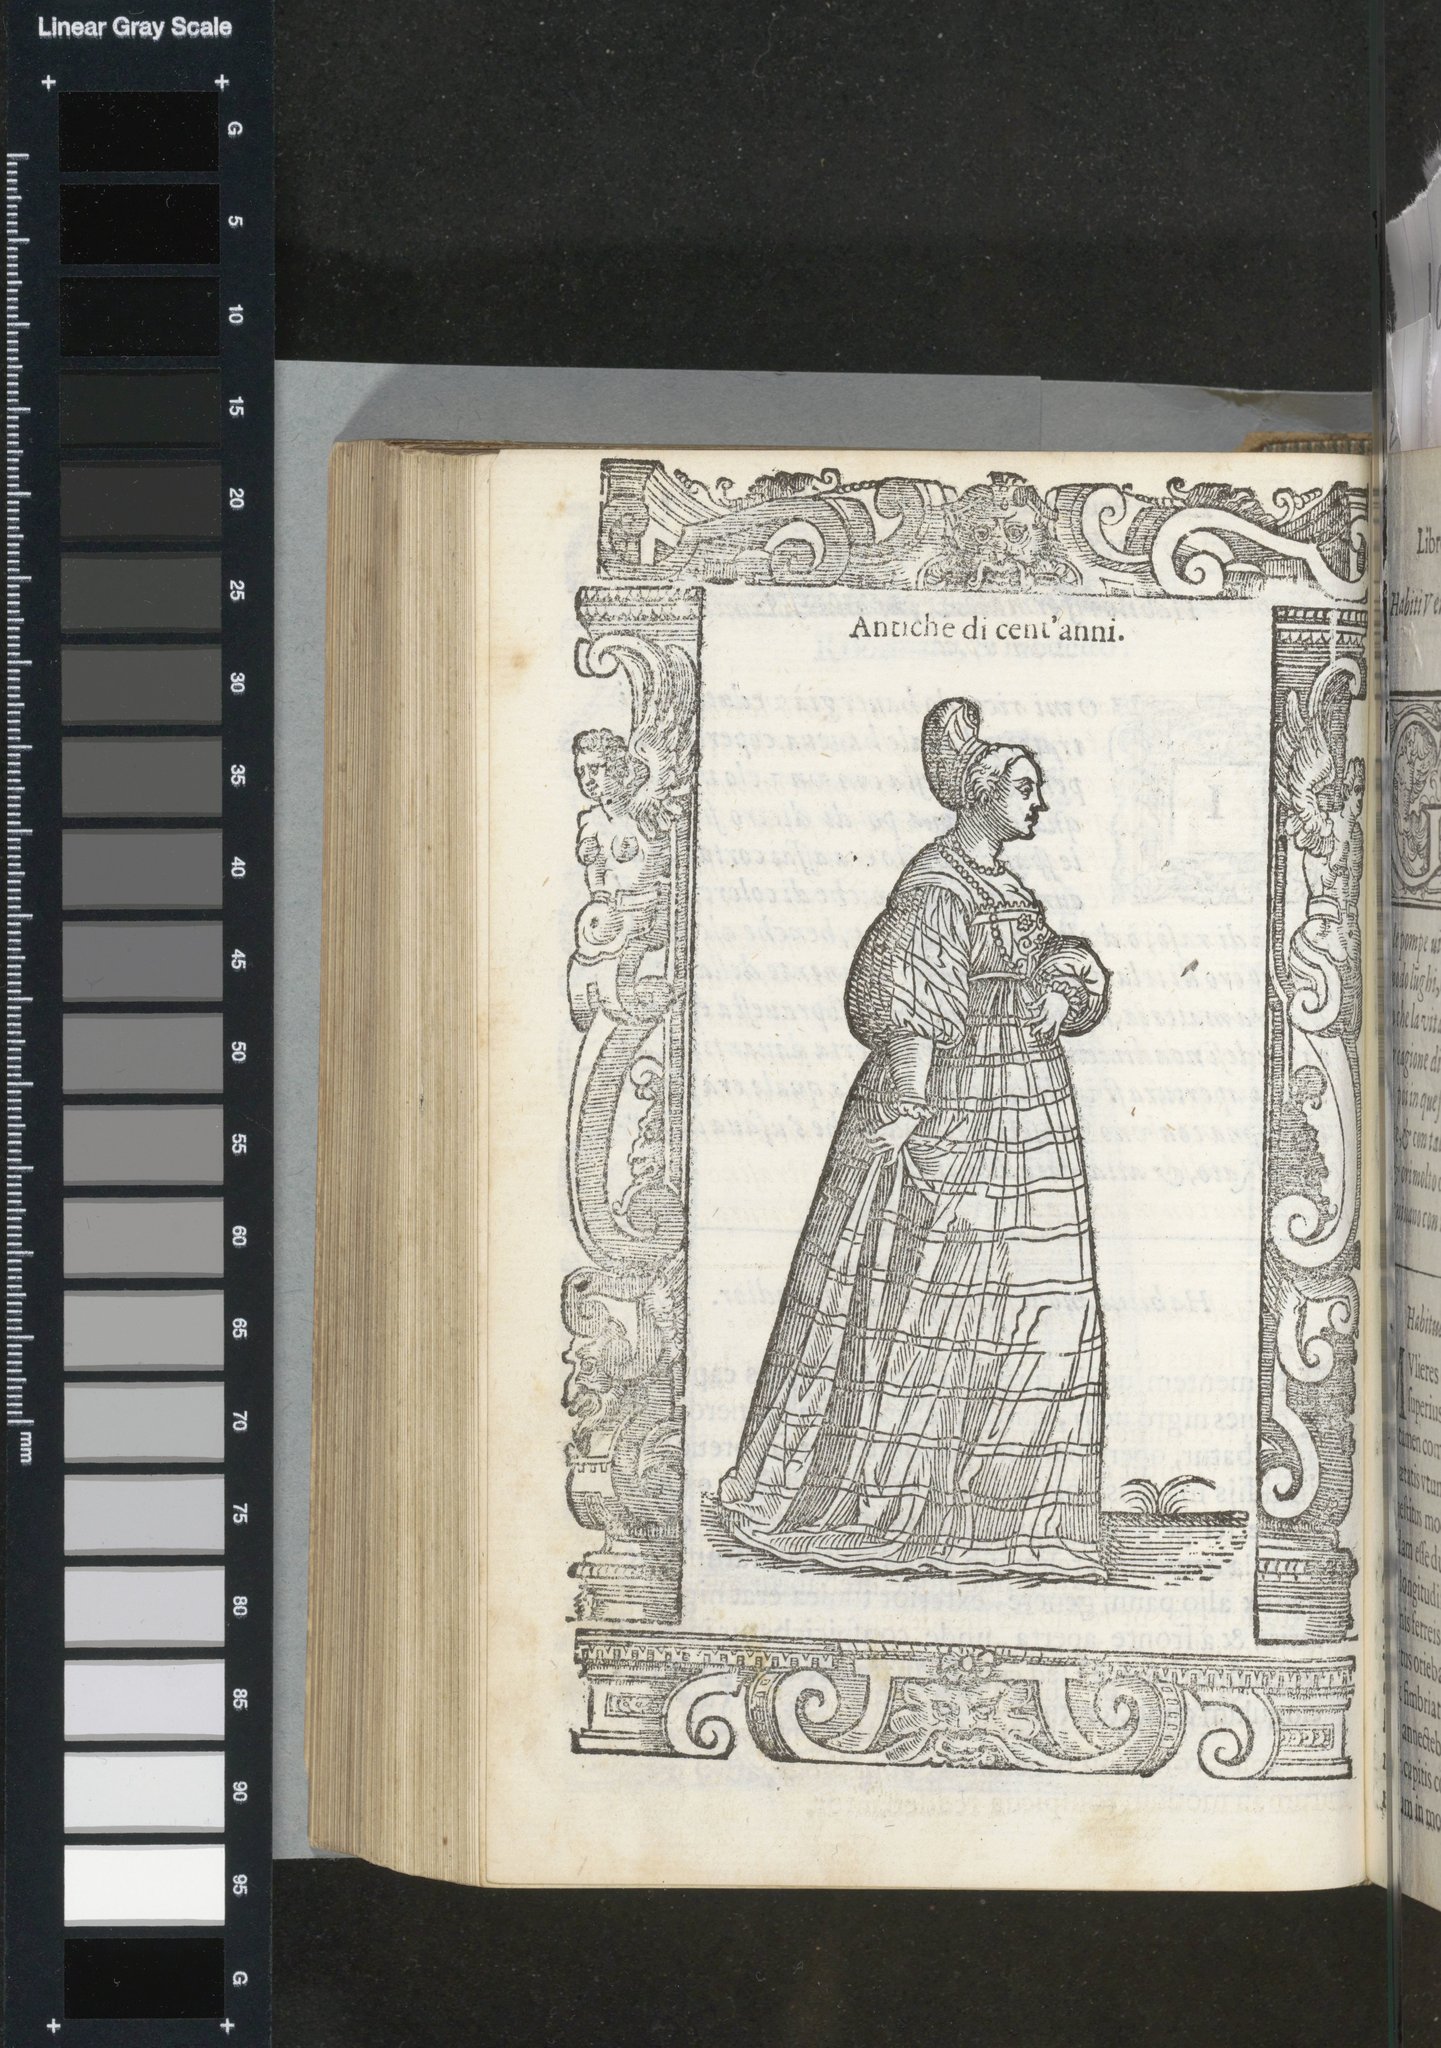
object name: costume print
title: Habiti antichi, et moderni di tutto il mondo..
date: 1598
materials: paper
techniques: woodcut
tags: fashion plates